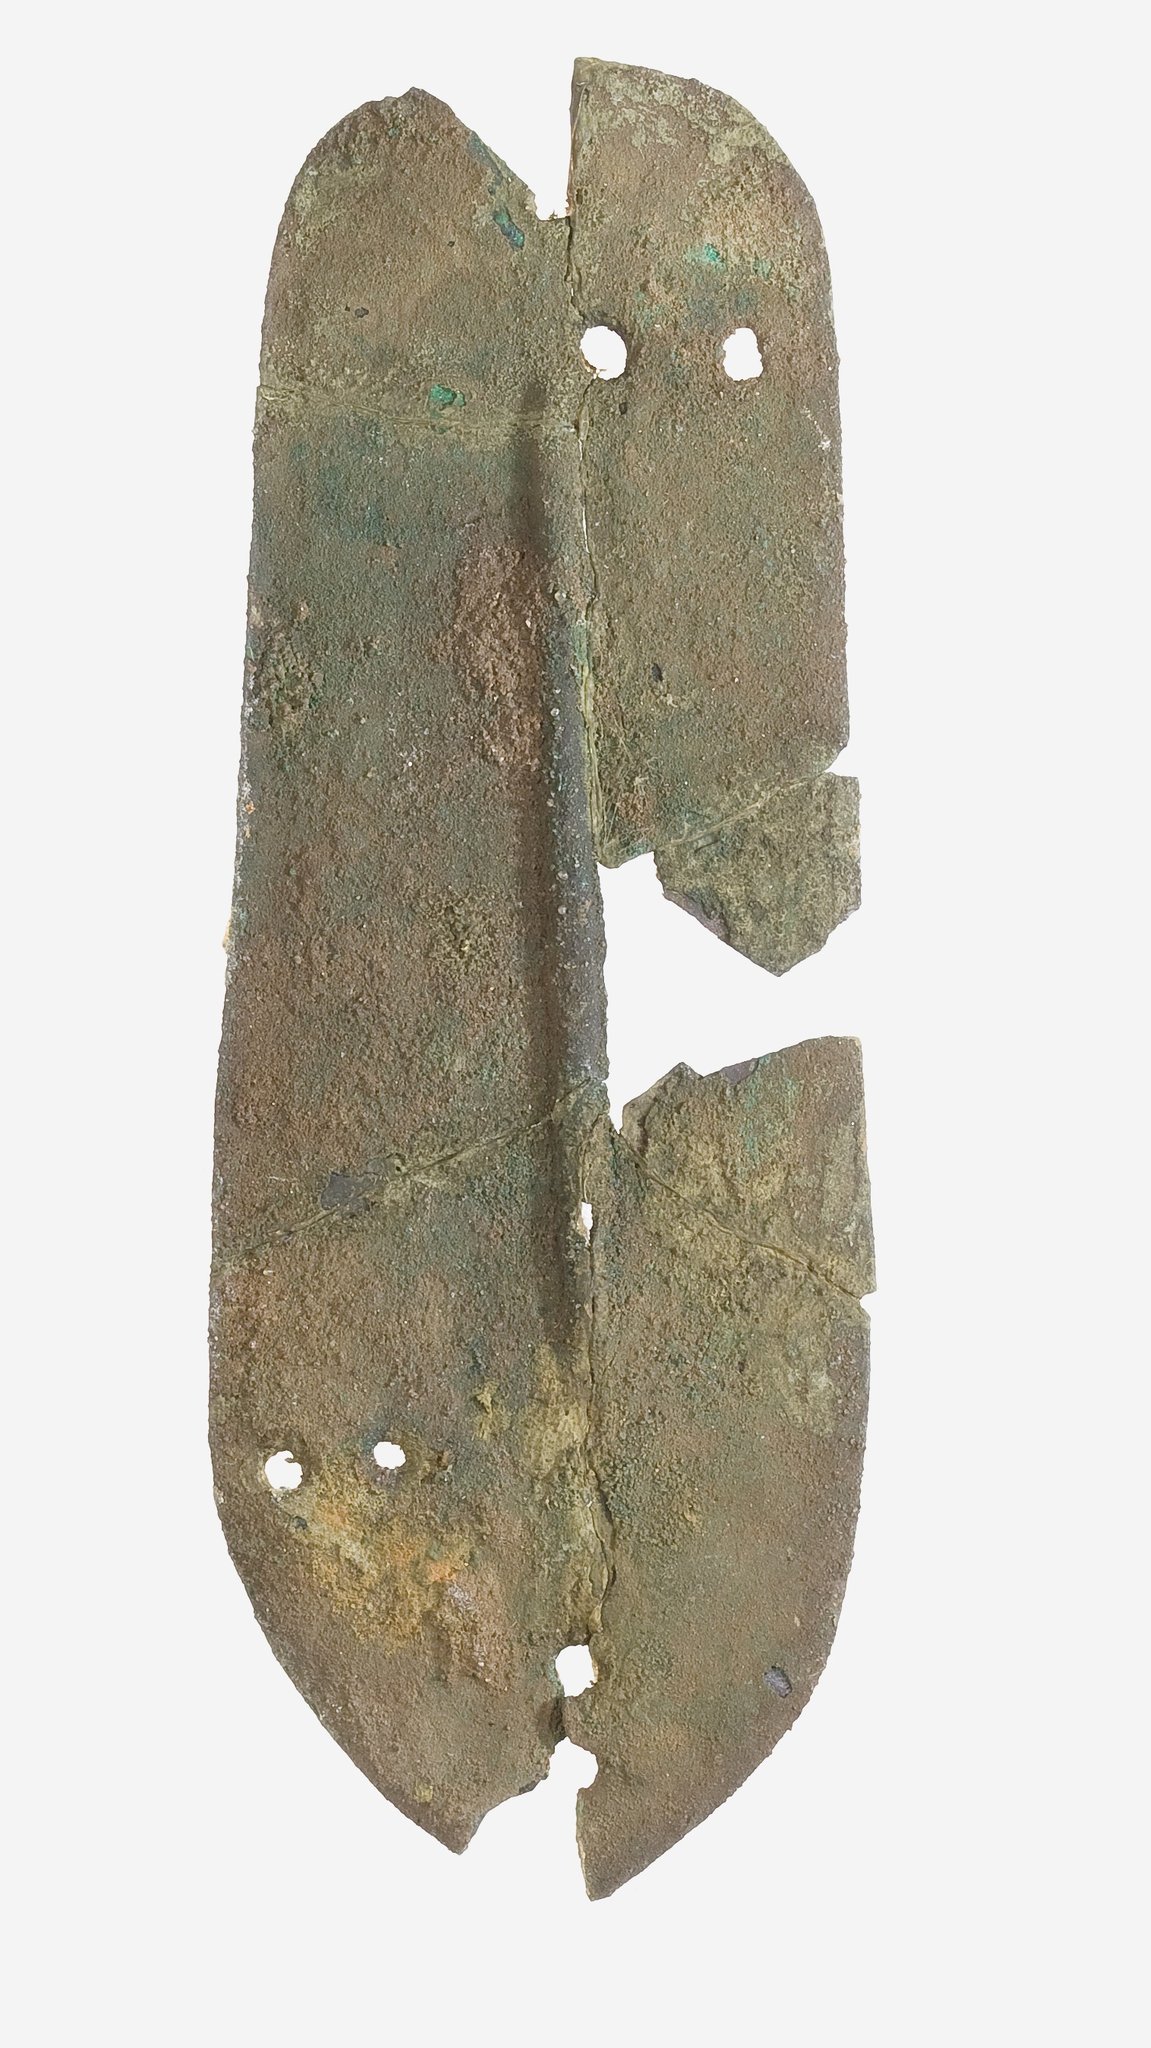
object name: armor scale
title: Scale from Armor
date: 1390-1352 BCE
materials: bronze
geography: egypt